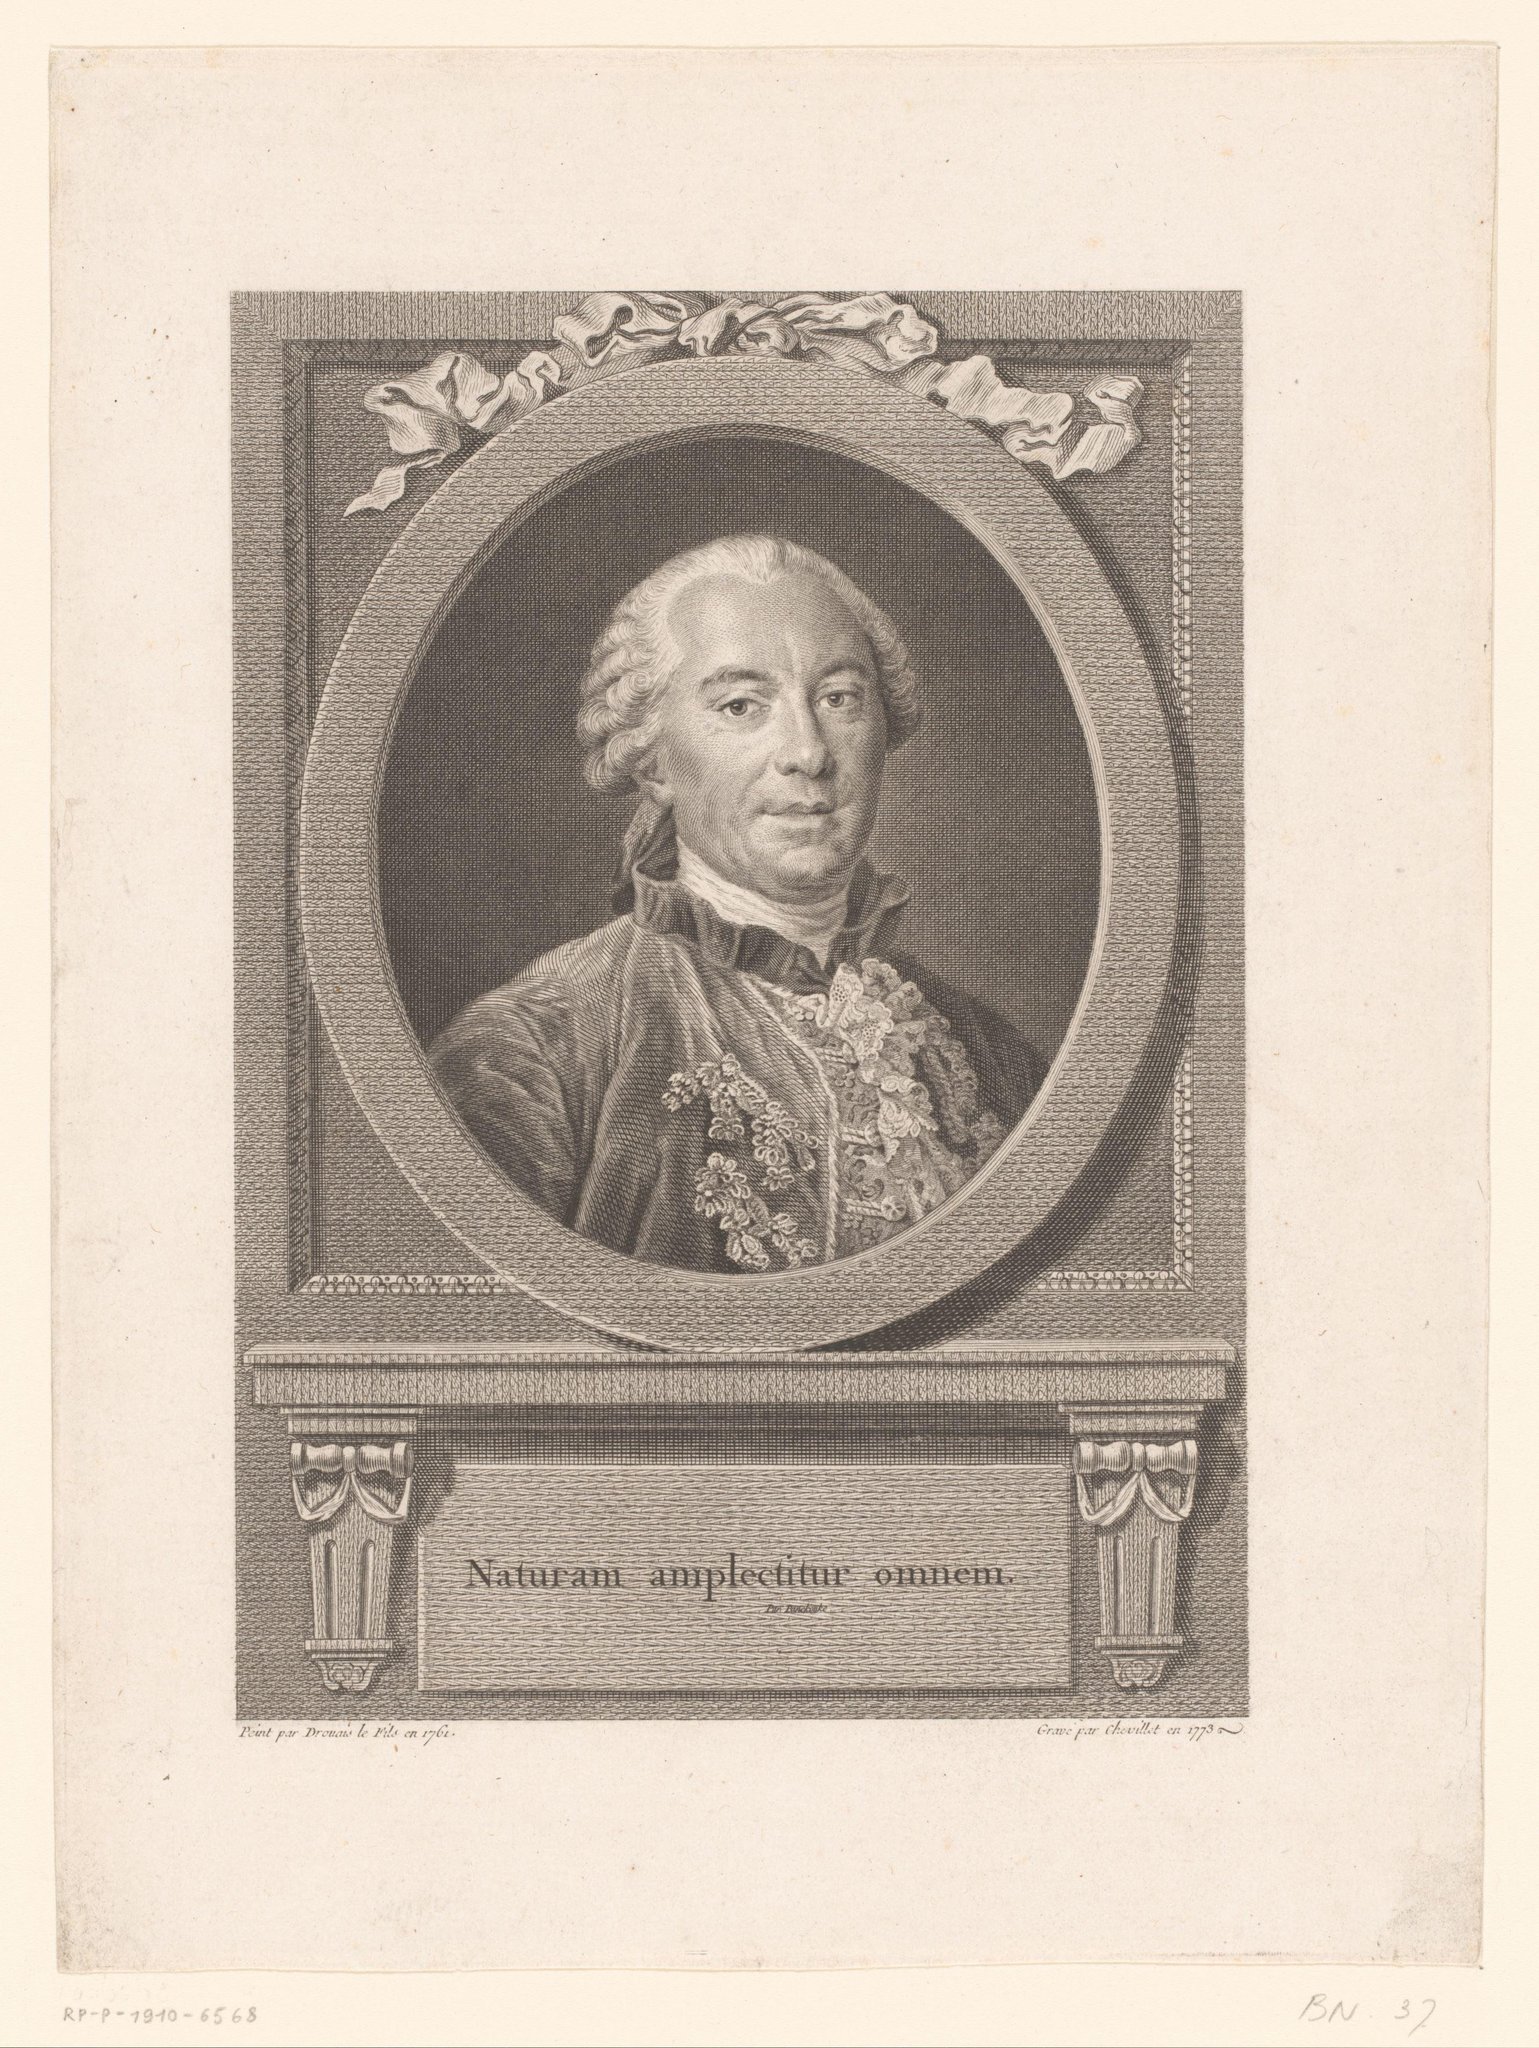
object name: print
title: Portret van Georges-Louis Leclerc de Buffon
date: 1773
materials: paper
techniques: engraving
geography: france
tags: paris, georges-louis leclerc de buffon (graaf), ornament ~ medallion, historical persons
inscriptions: collector's mark: Lugt 2228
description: Mogelijk prent uit: Buffon, Georges-Louis Leclerc de. Histoire Naturelle, Générale Et Particulière. Zweibrücken: Sanson & Compagnie, 1749-1804.